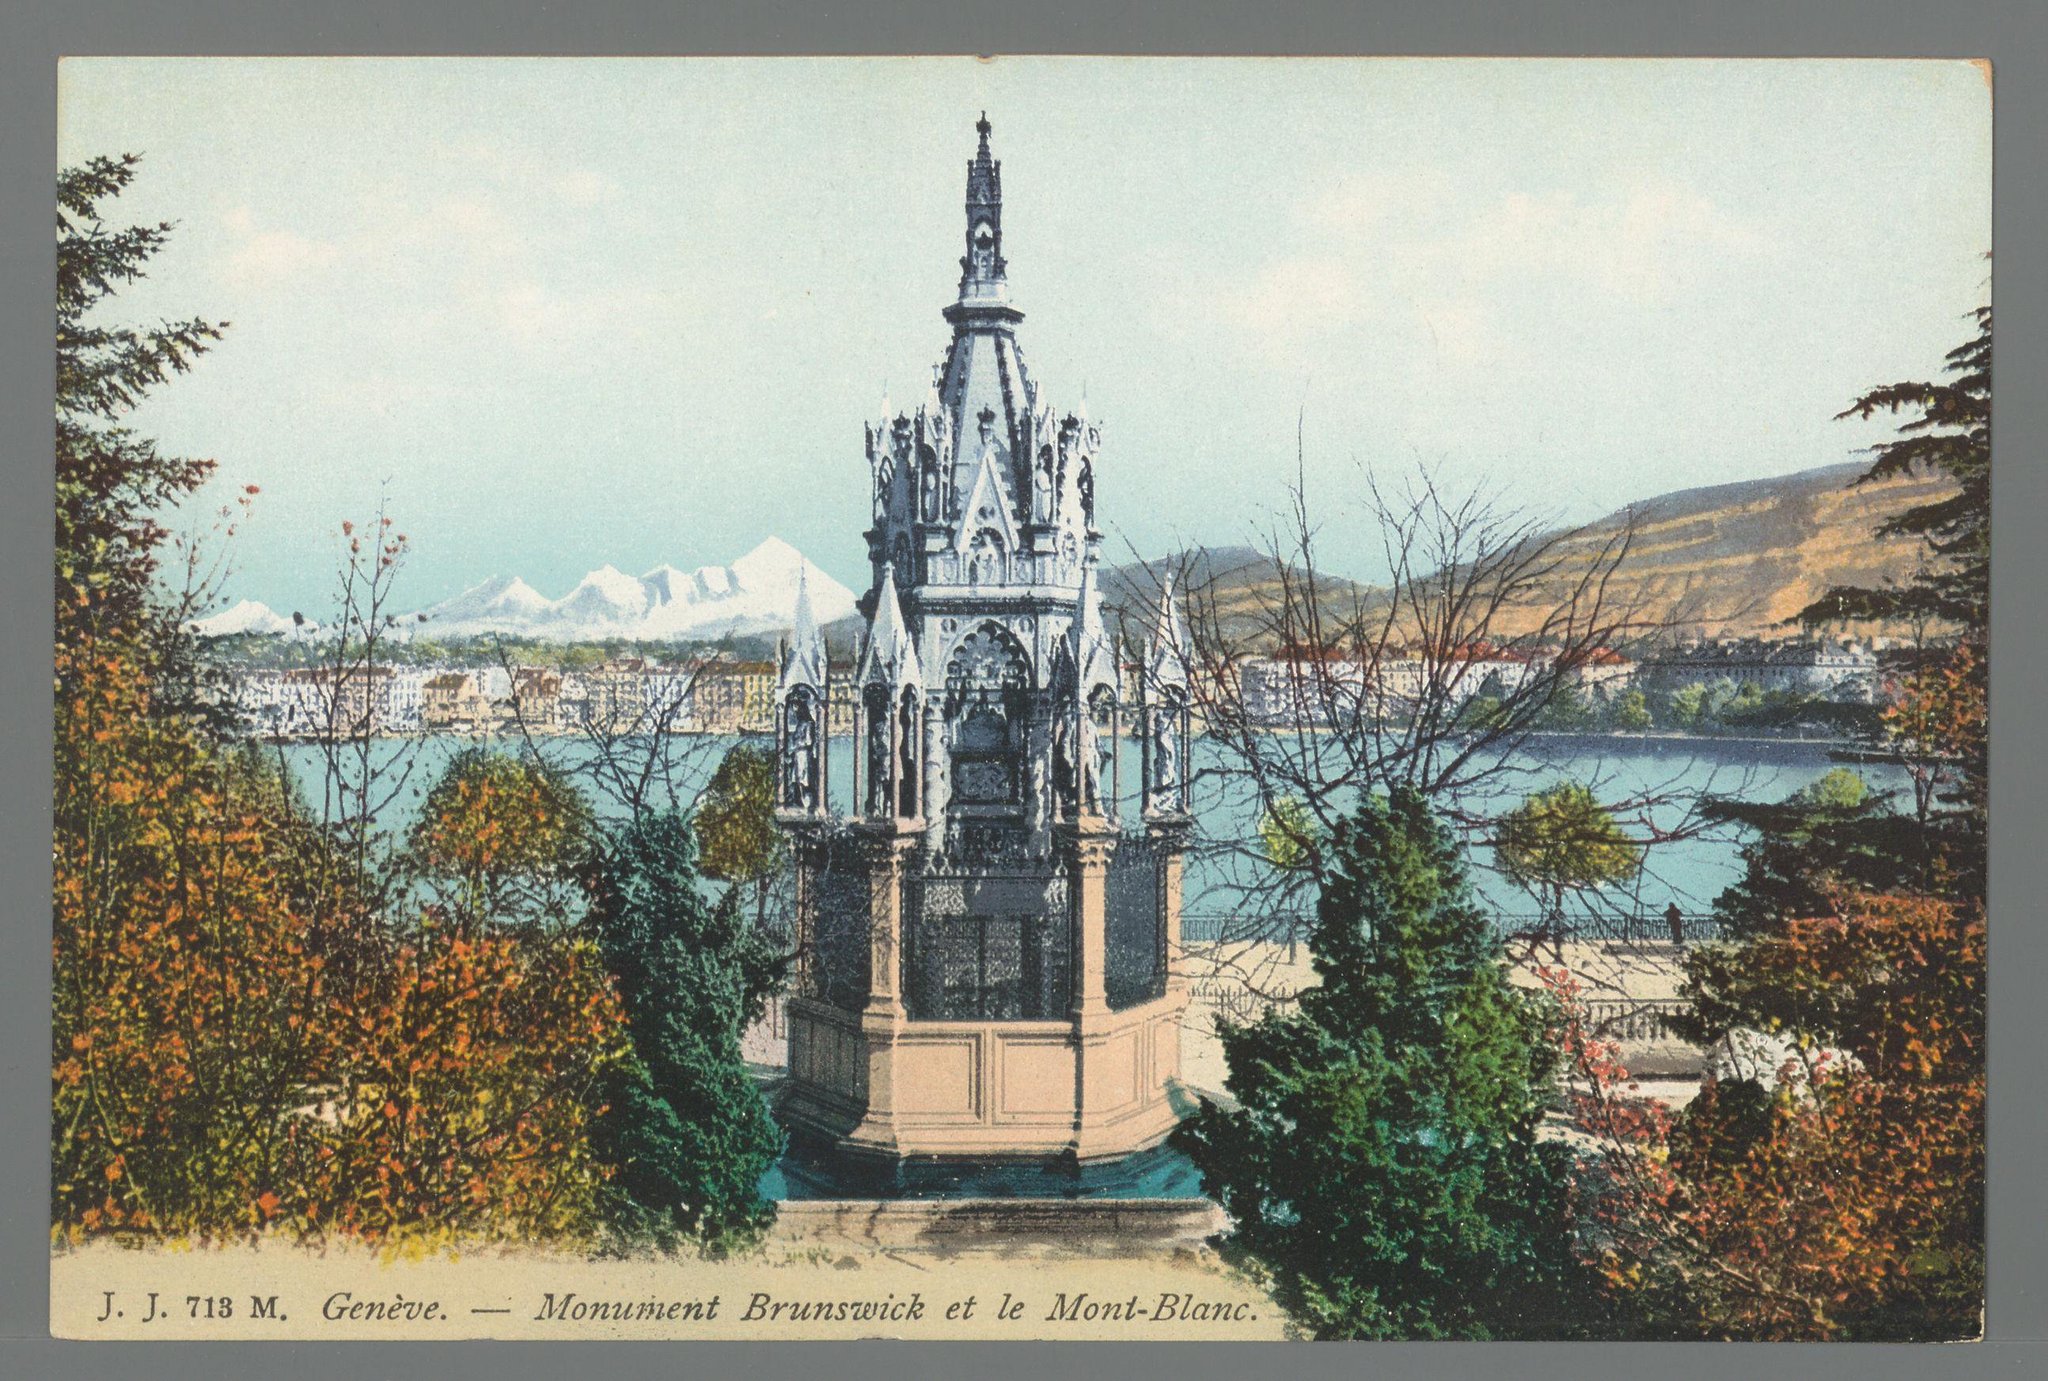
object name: ansichtkaart, prentbriefkaart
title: Genève. Monument Brunswick et le Mont-Blanc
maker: Anonymous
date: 1905-1918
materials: cardboard, photographic process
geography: geneva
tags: lake, monument, statue, city-view, and landscape with man-made constructions (+ city(-scape) with figures, staffage)